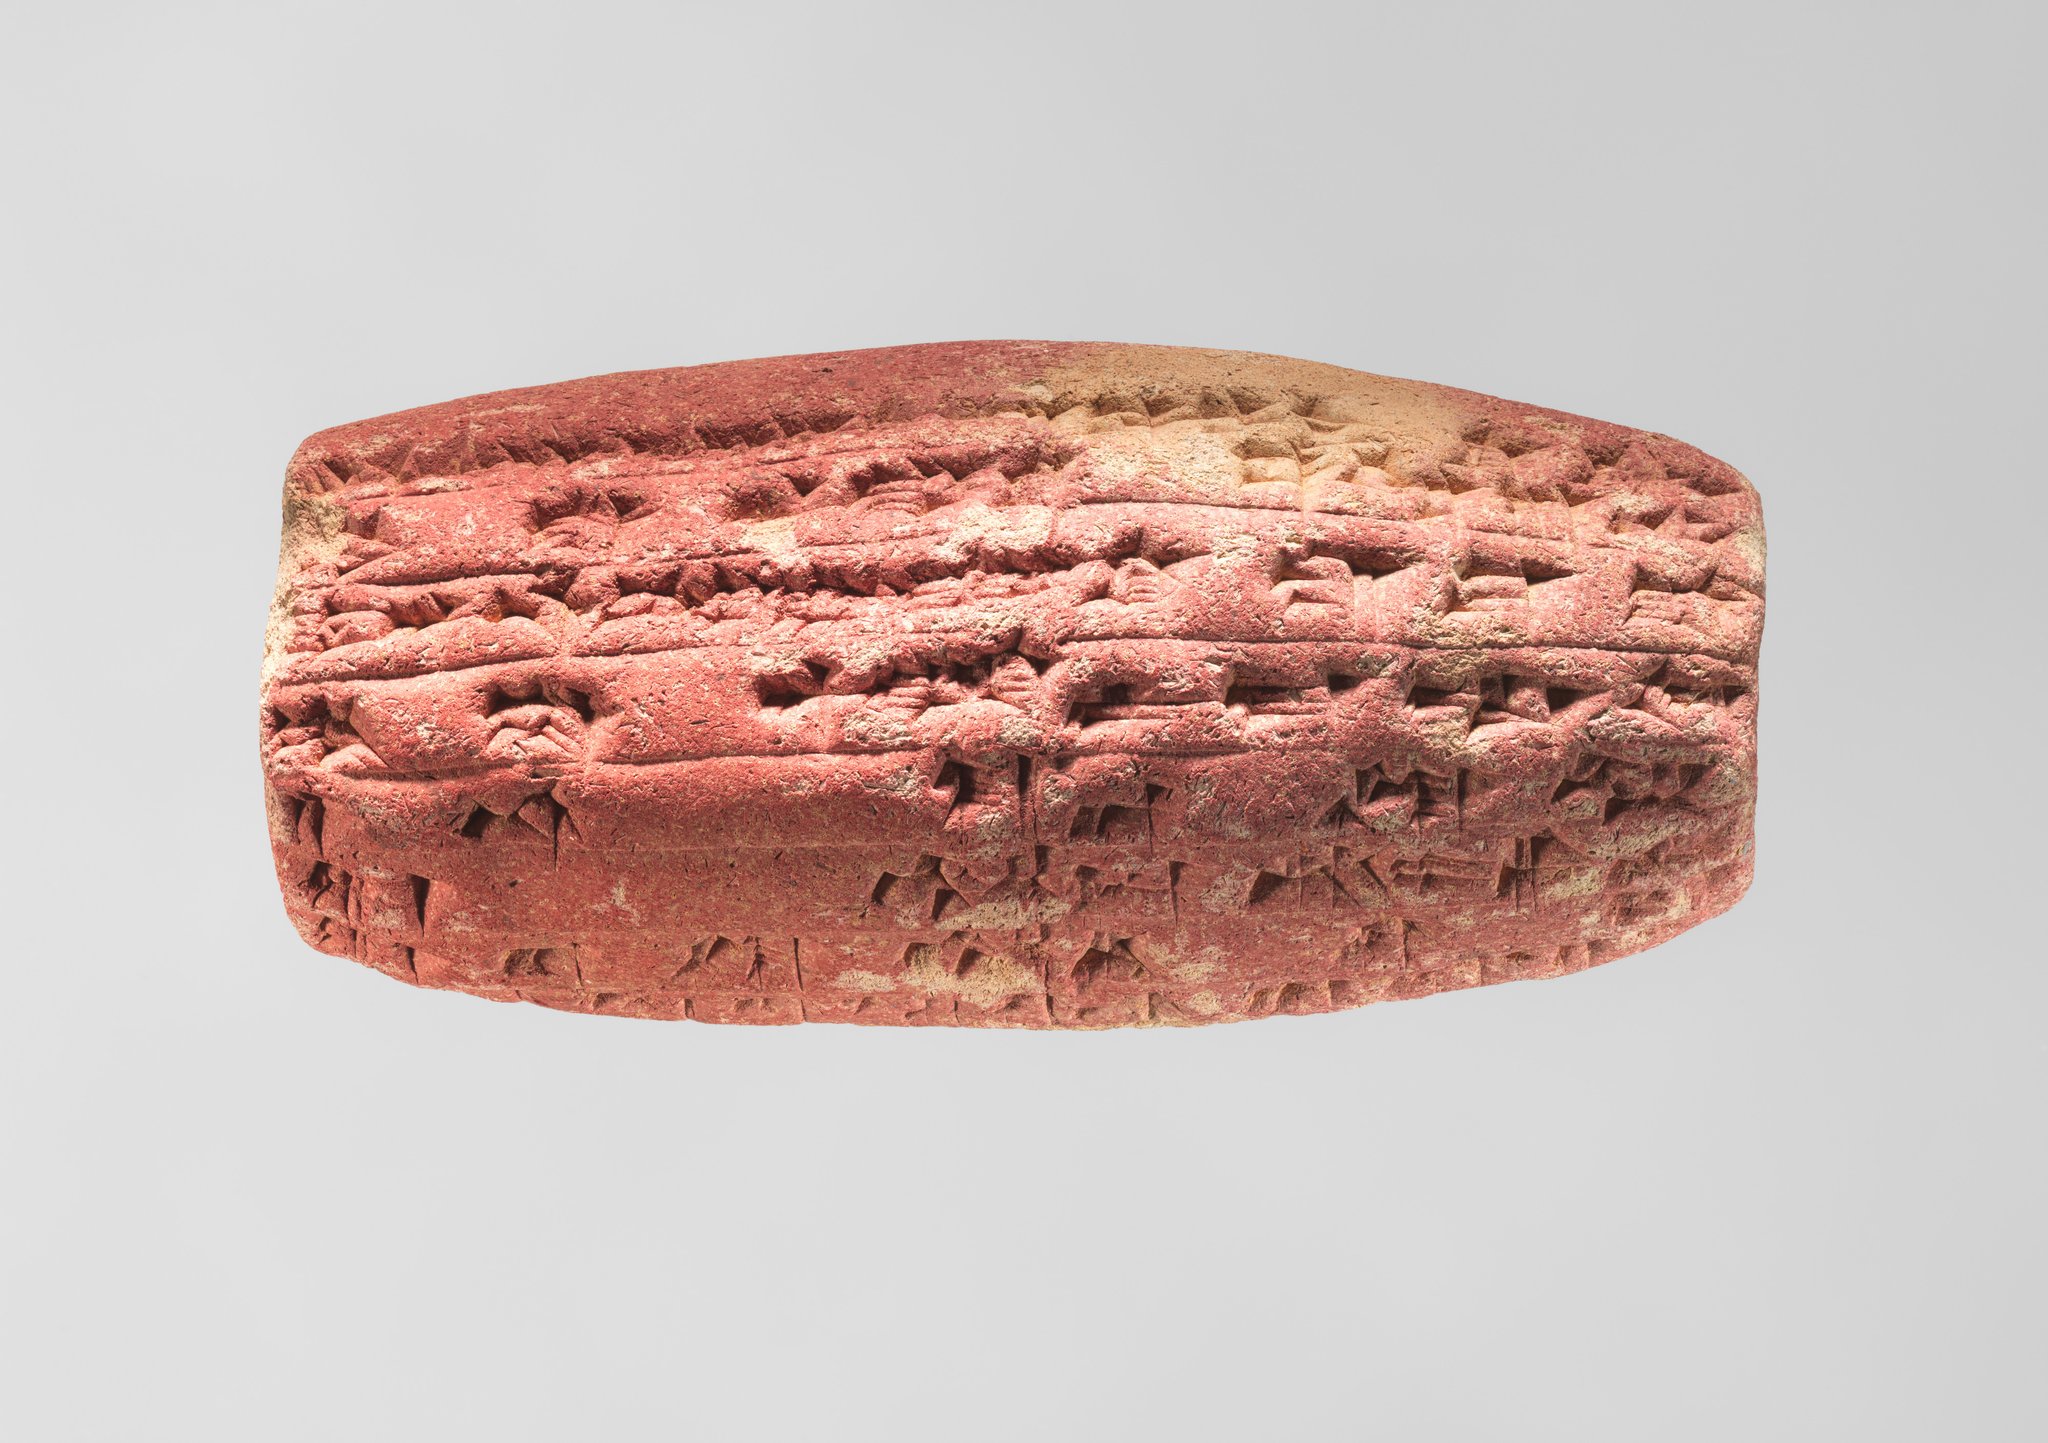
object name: cuneiform cylinder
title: Cuneiform cylinder with inscription of Nebuchadnezzar II describing the rebuilding of the temple of the mother-goddess Ninmah/Belet-ili at Babylon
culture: babylonian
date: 604-562 BCE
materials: clay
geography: mesopotamia